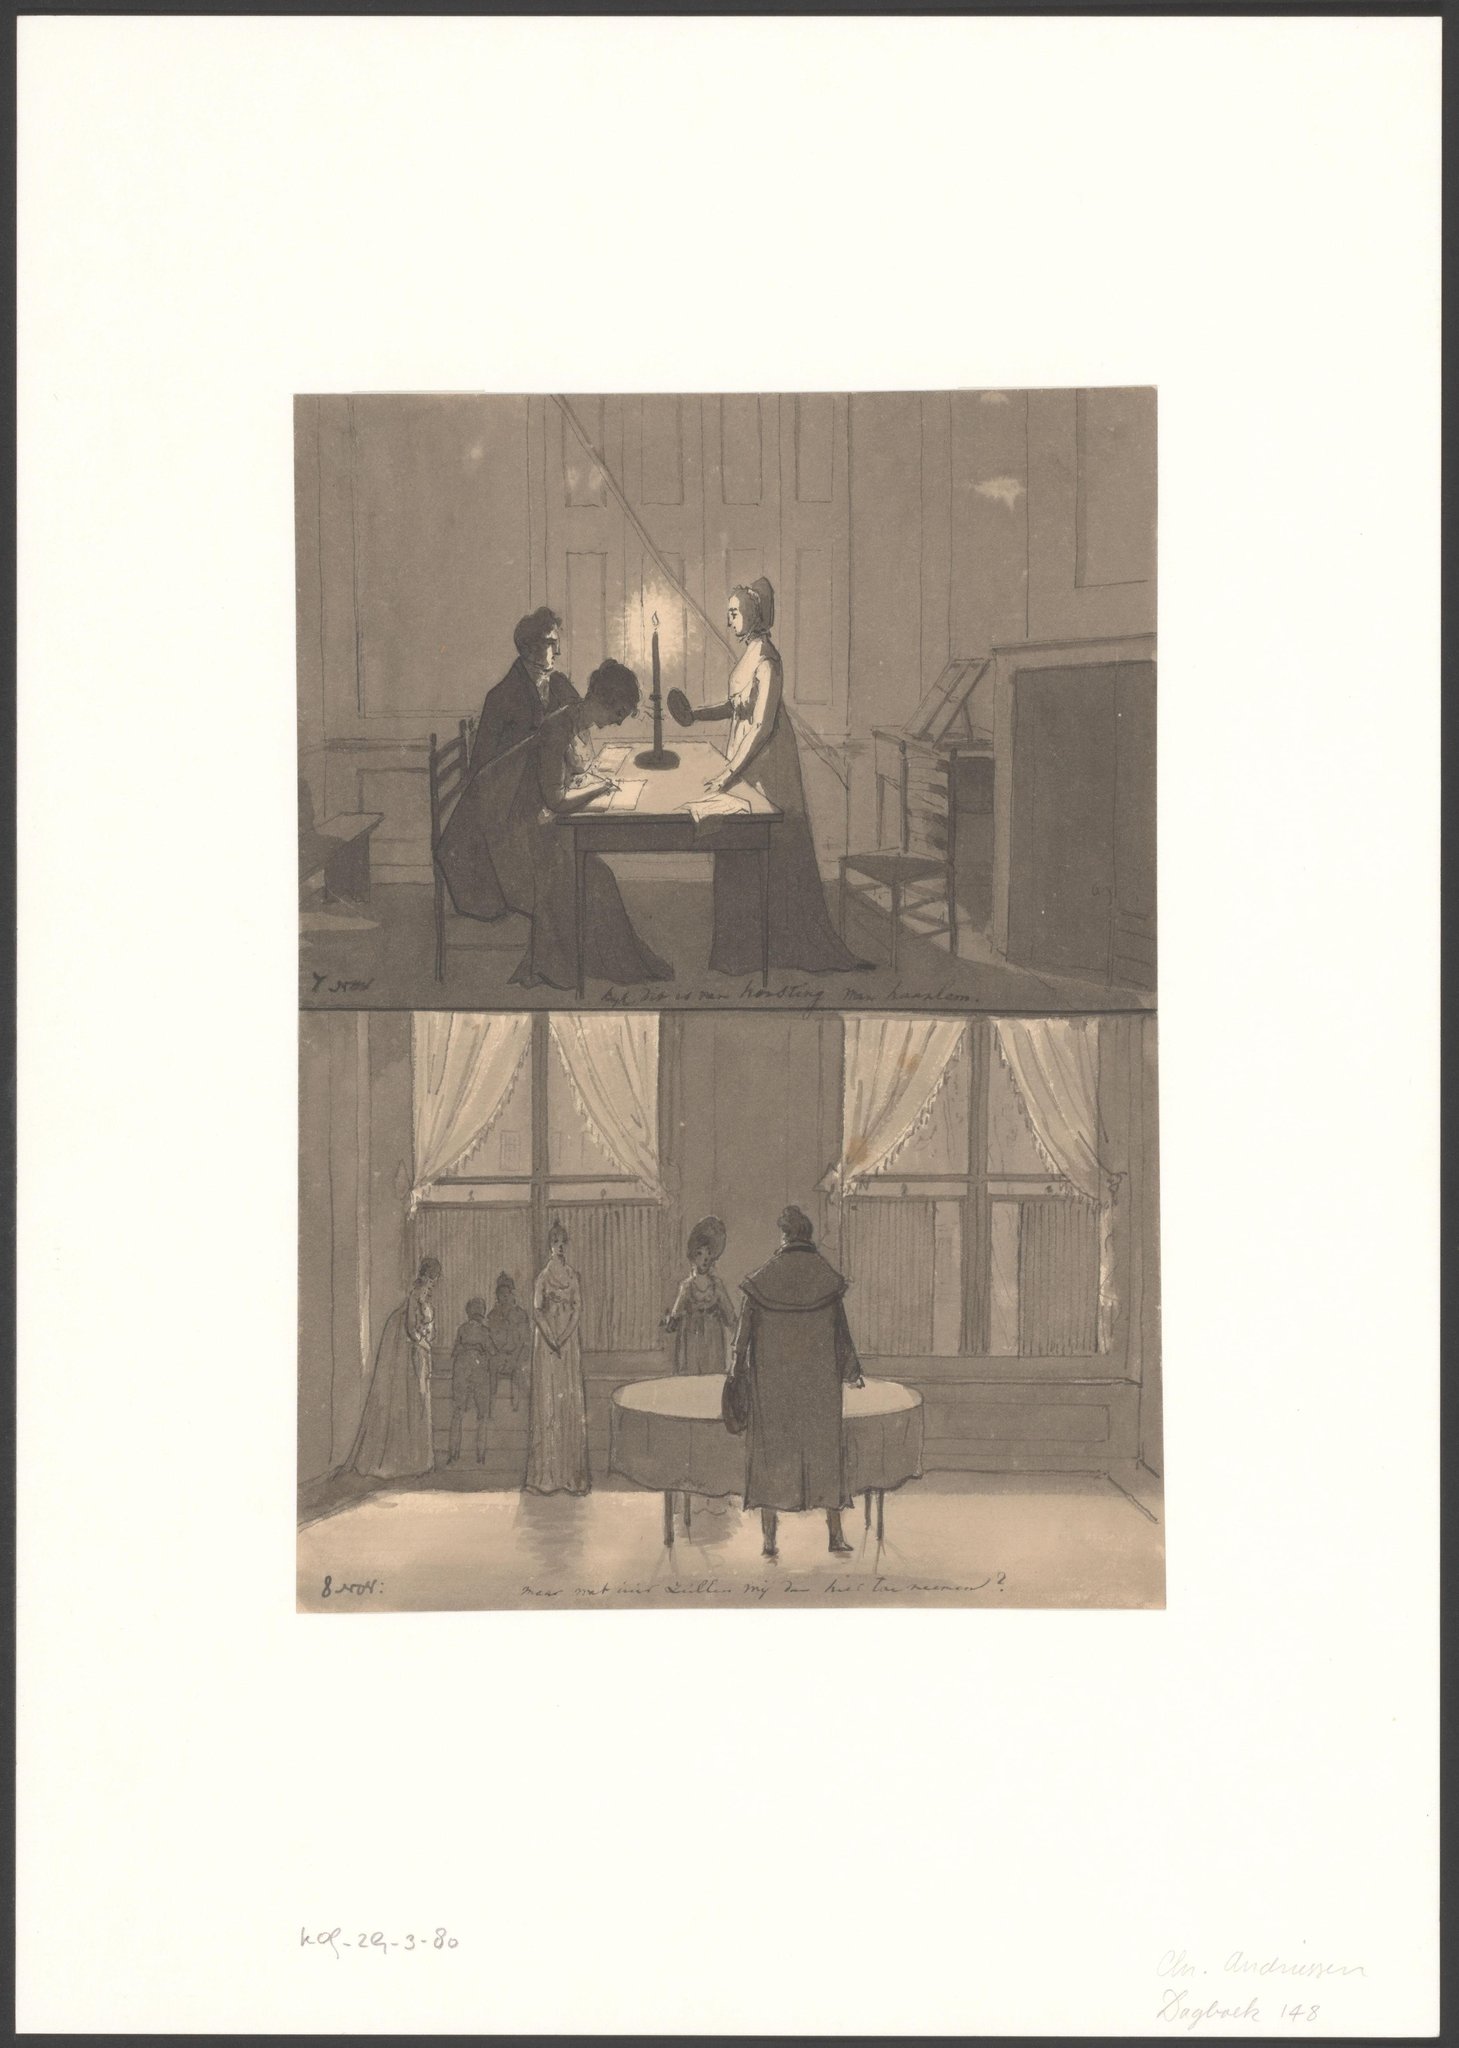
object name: drawing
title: Christiaan Andriessen met twee vrouwen werk van Hoosting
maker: christiaan andriessen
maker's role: draughtsman, print maker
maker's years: 1775-1846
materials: ink, paper, pencil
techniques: brush, pen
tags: drawing, sketch, interior of the house, candlestick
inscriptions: inscription, inscription: ‘7 nov kijk dit is van Hoosting van Haarlem / 8 nov maar wat uurzullen wij dan daartoe neemen?’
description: Twee voorstellingen onder en boven. Bovenaan bekijkt Christiaan Andriessen met twee vrouwen werk van Hoosting.